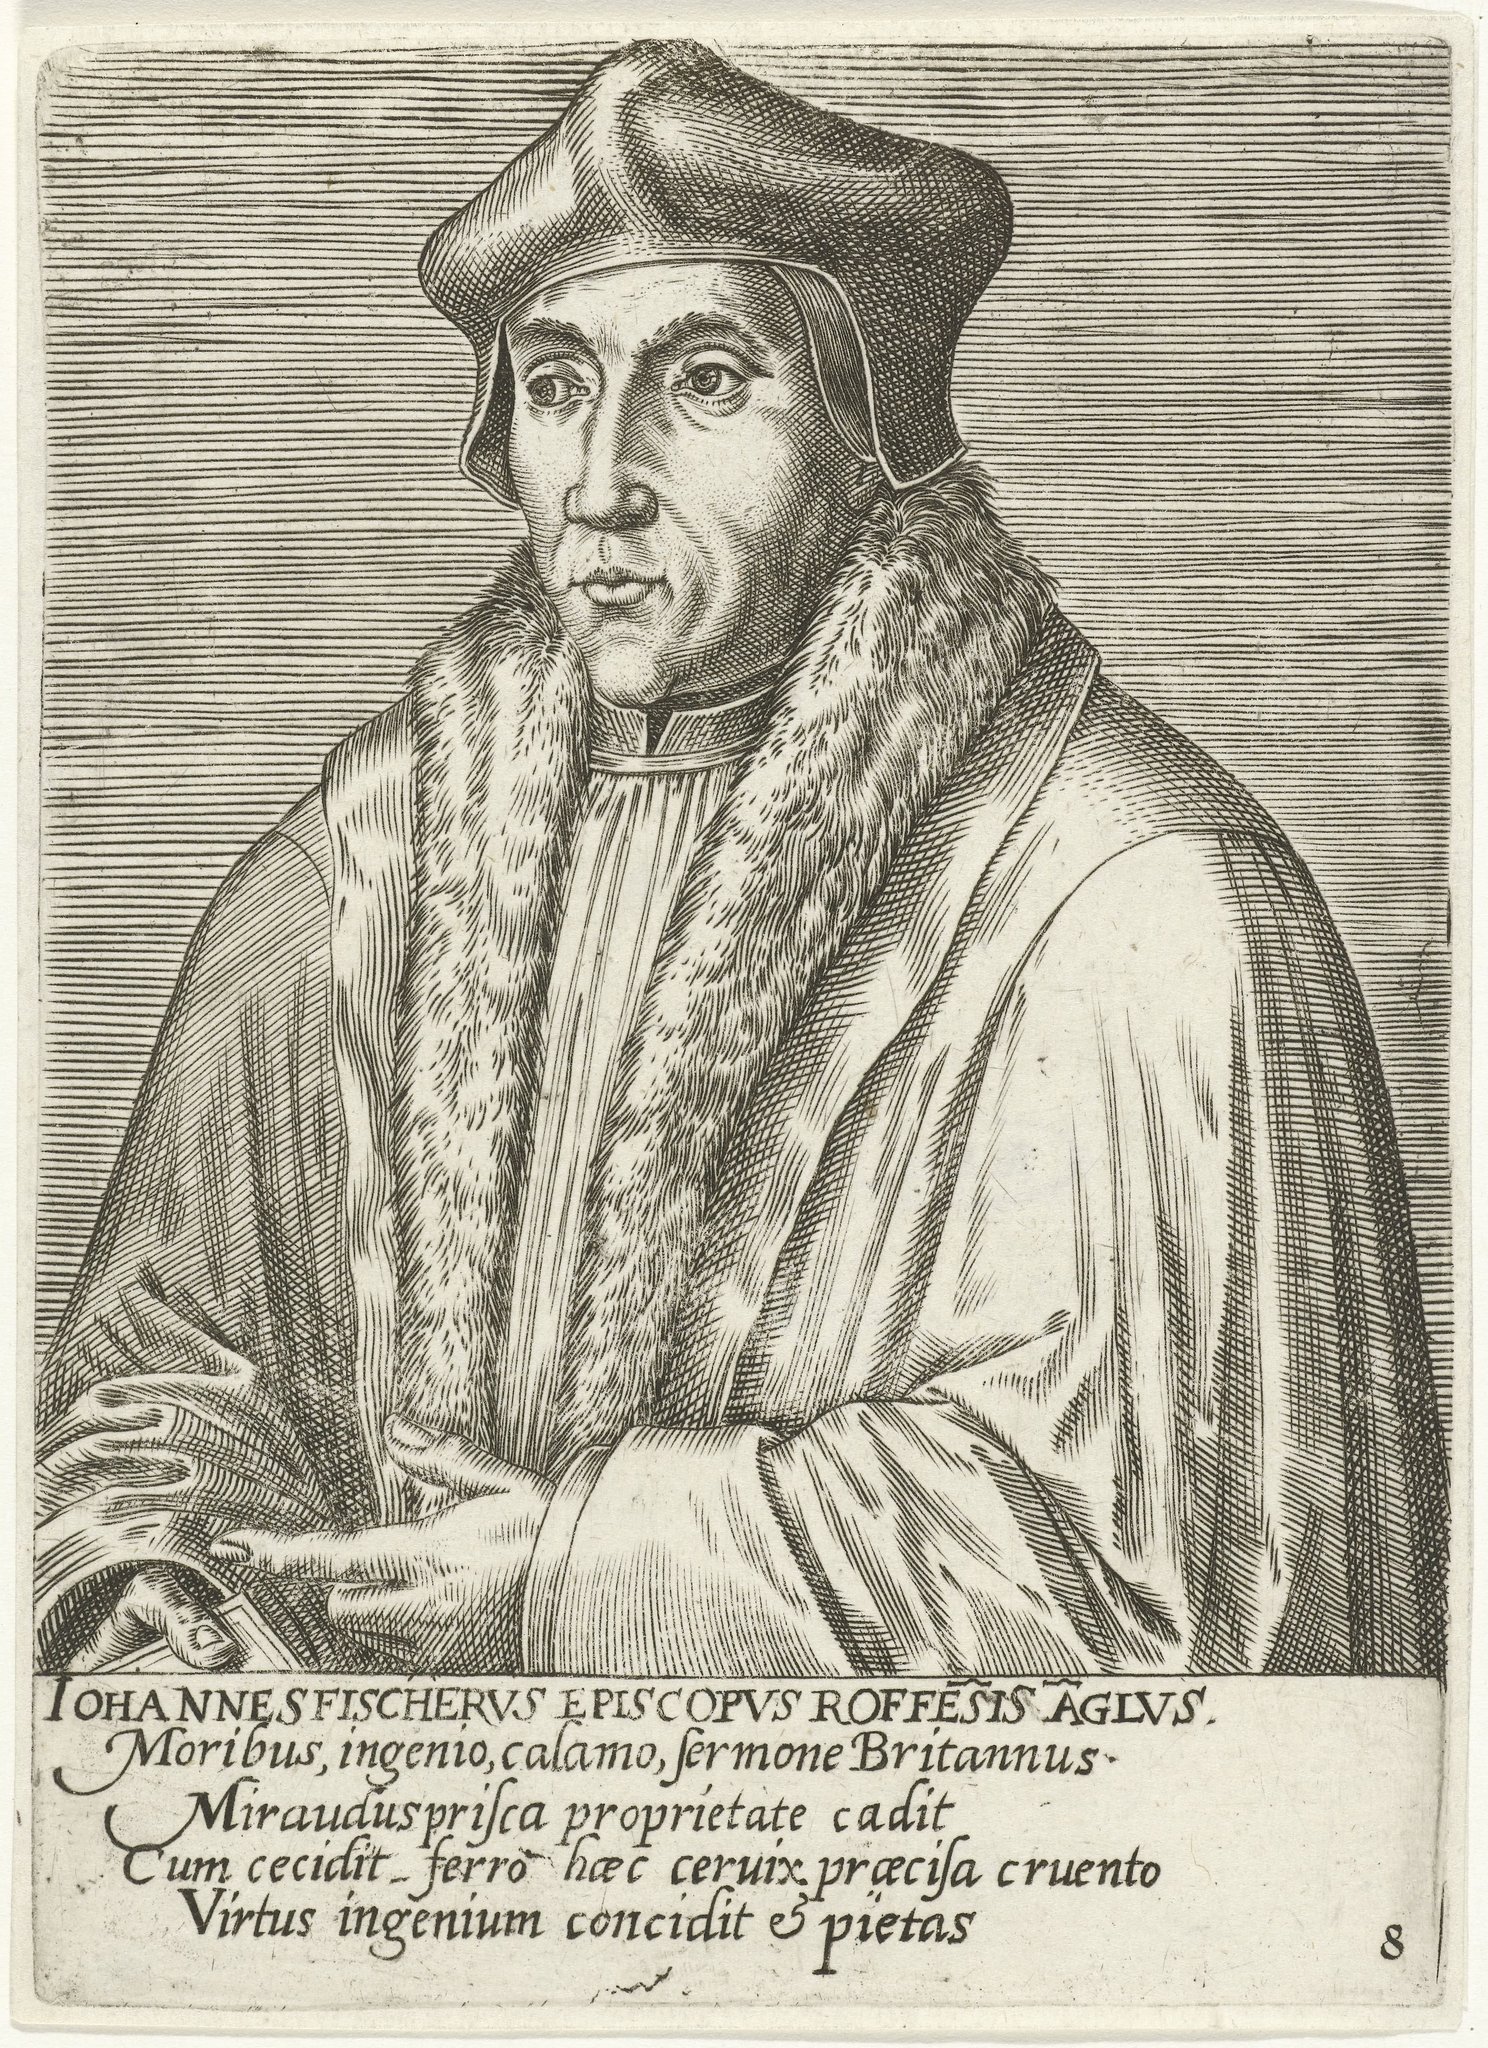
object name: print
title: Portretten van beroemde Europese geleerden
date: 1572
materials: paper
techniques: engraving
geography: antwerp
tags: london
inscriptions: collector's mark: Lugt 2228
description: Portret van John Fischer, bisschop van Rochester en Engels humanist. Buste naar links. De prent heeft een Latijns onderschrift en maakt deel uit van een serie van beroemde Europese geleerden